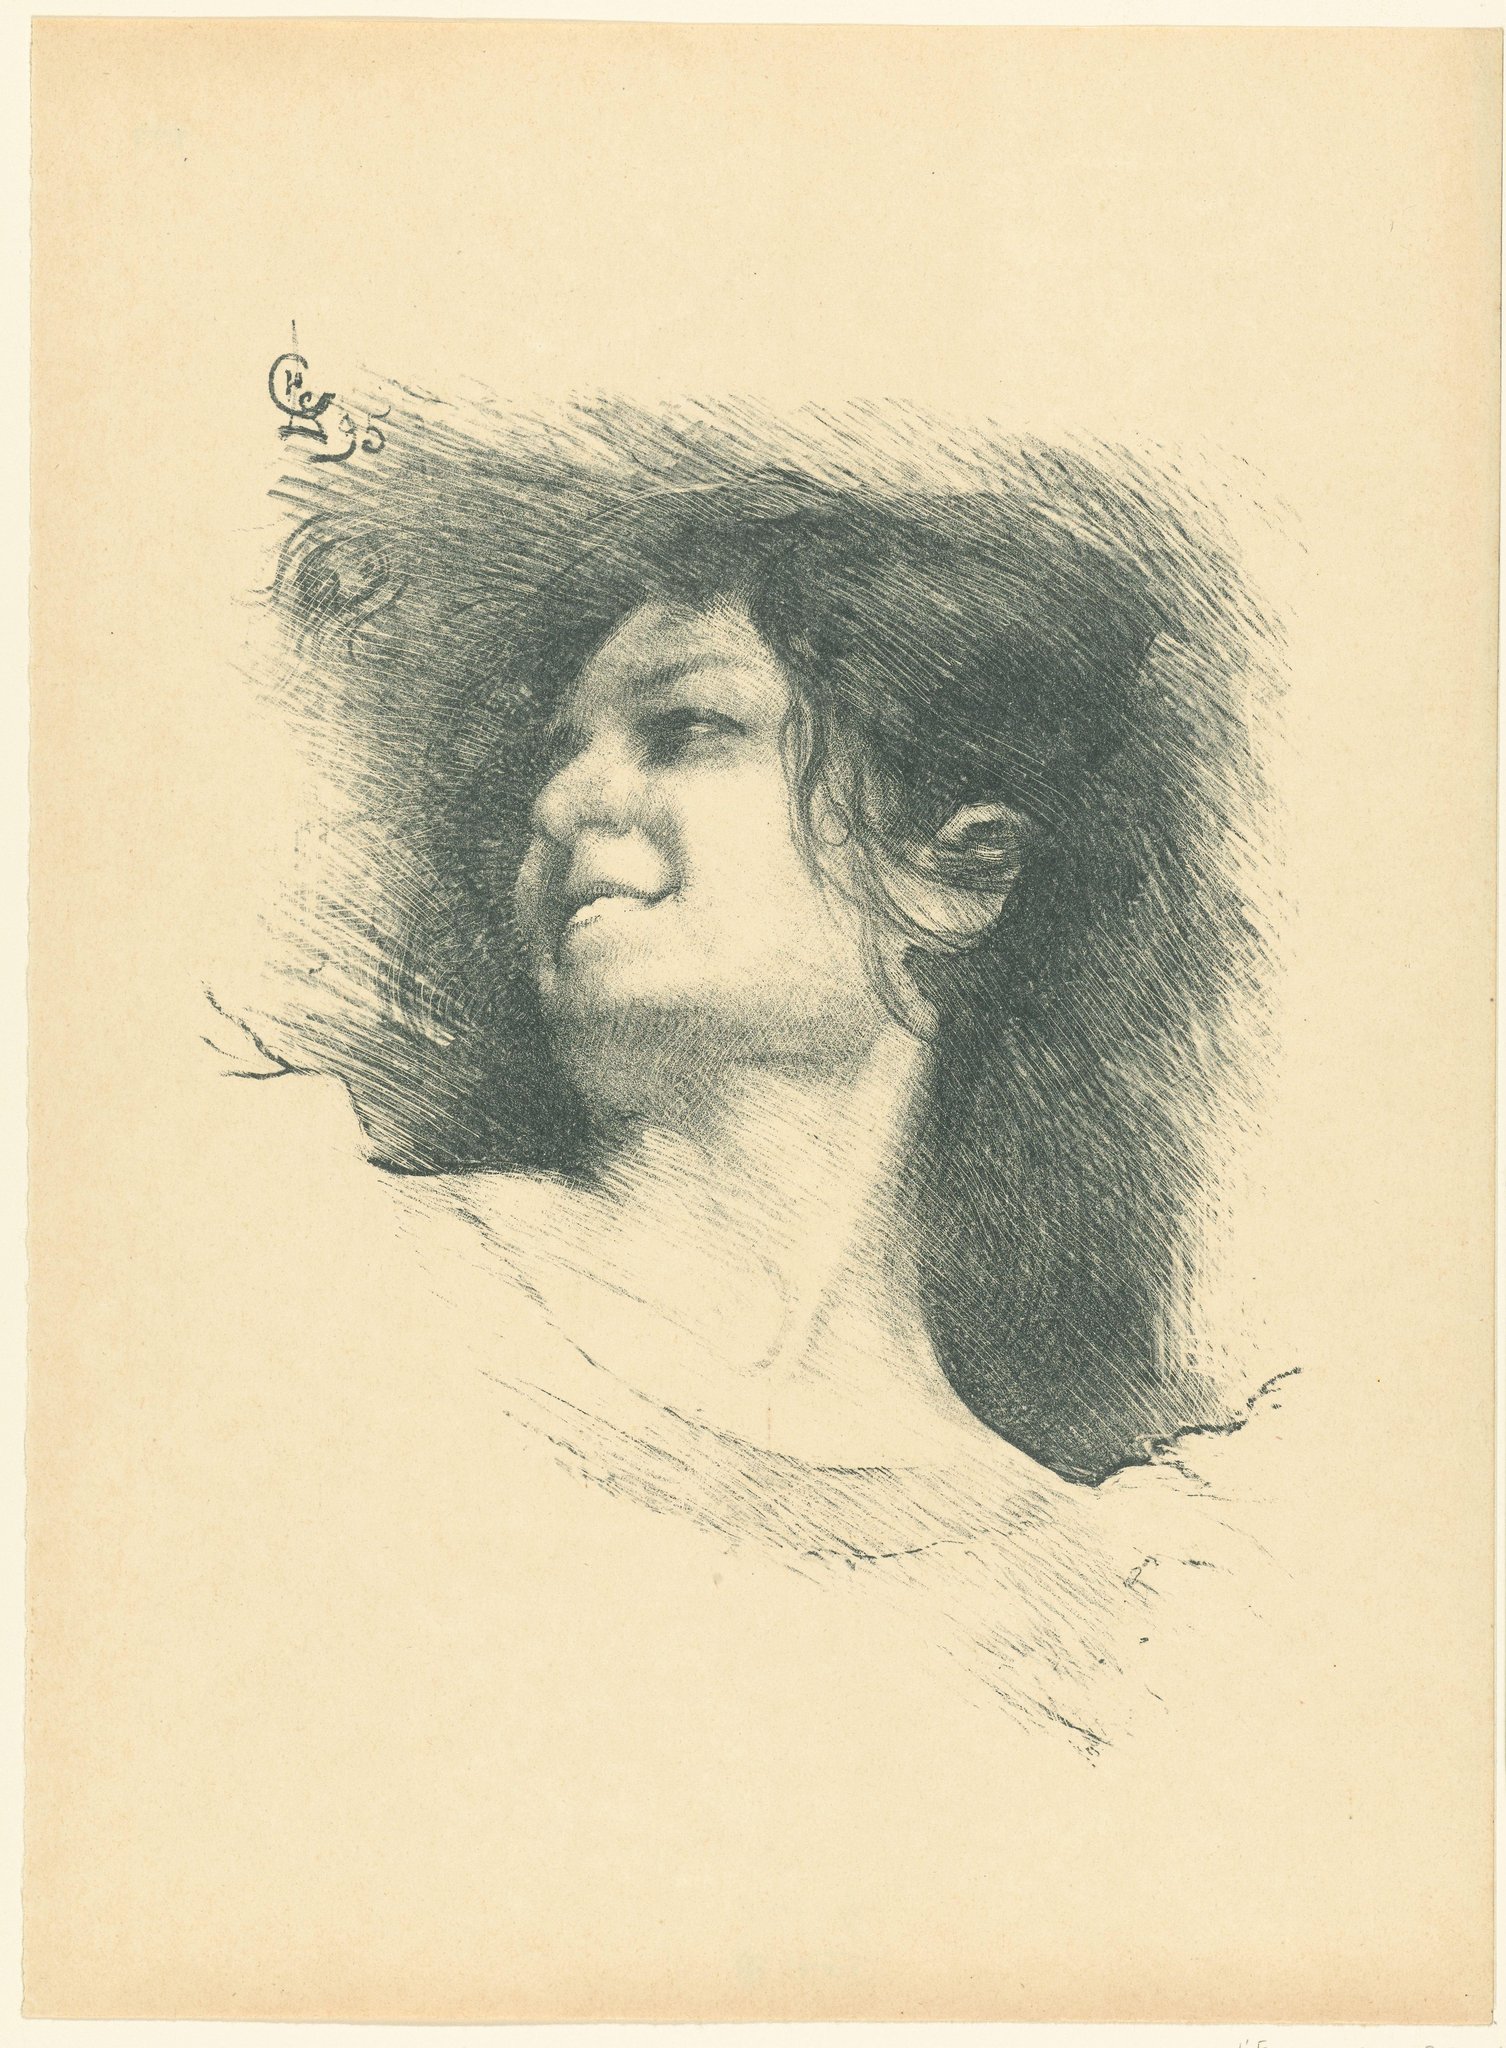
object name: print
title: Hoofd van lachende vrouw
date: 1806-1895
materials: paper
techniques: printing, lithograph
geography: paris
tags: head (human), female sex; woman, laughing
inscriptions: collector's mark: Lugt 2760, collector's mark: Lugt 2228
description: Verschenen in album met tien originele prenten als supplement bij tijdschrift: L'Epreuve, juni 1895, prent nr. 6